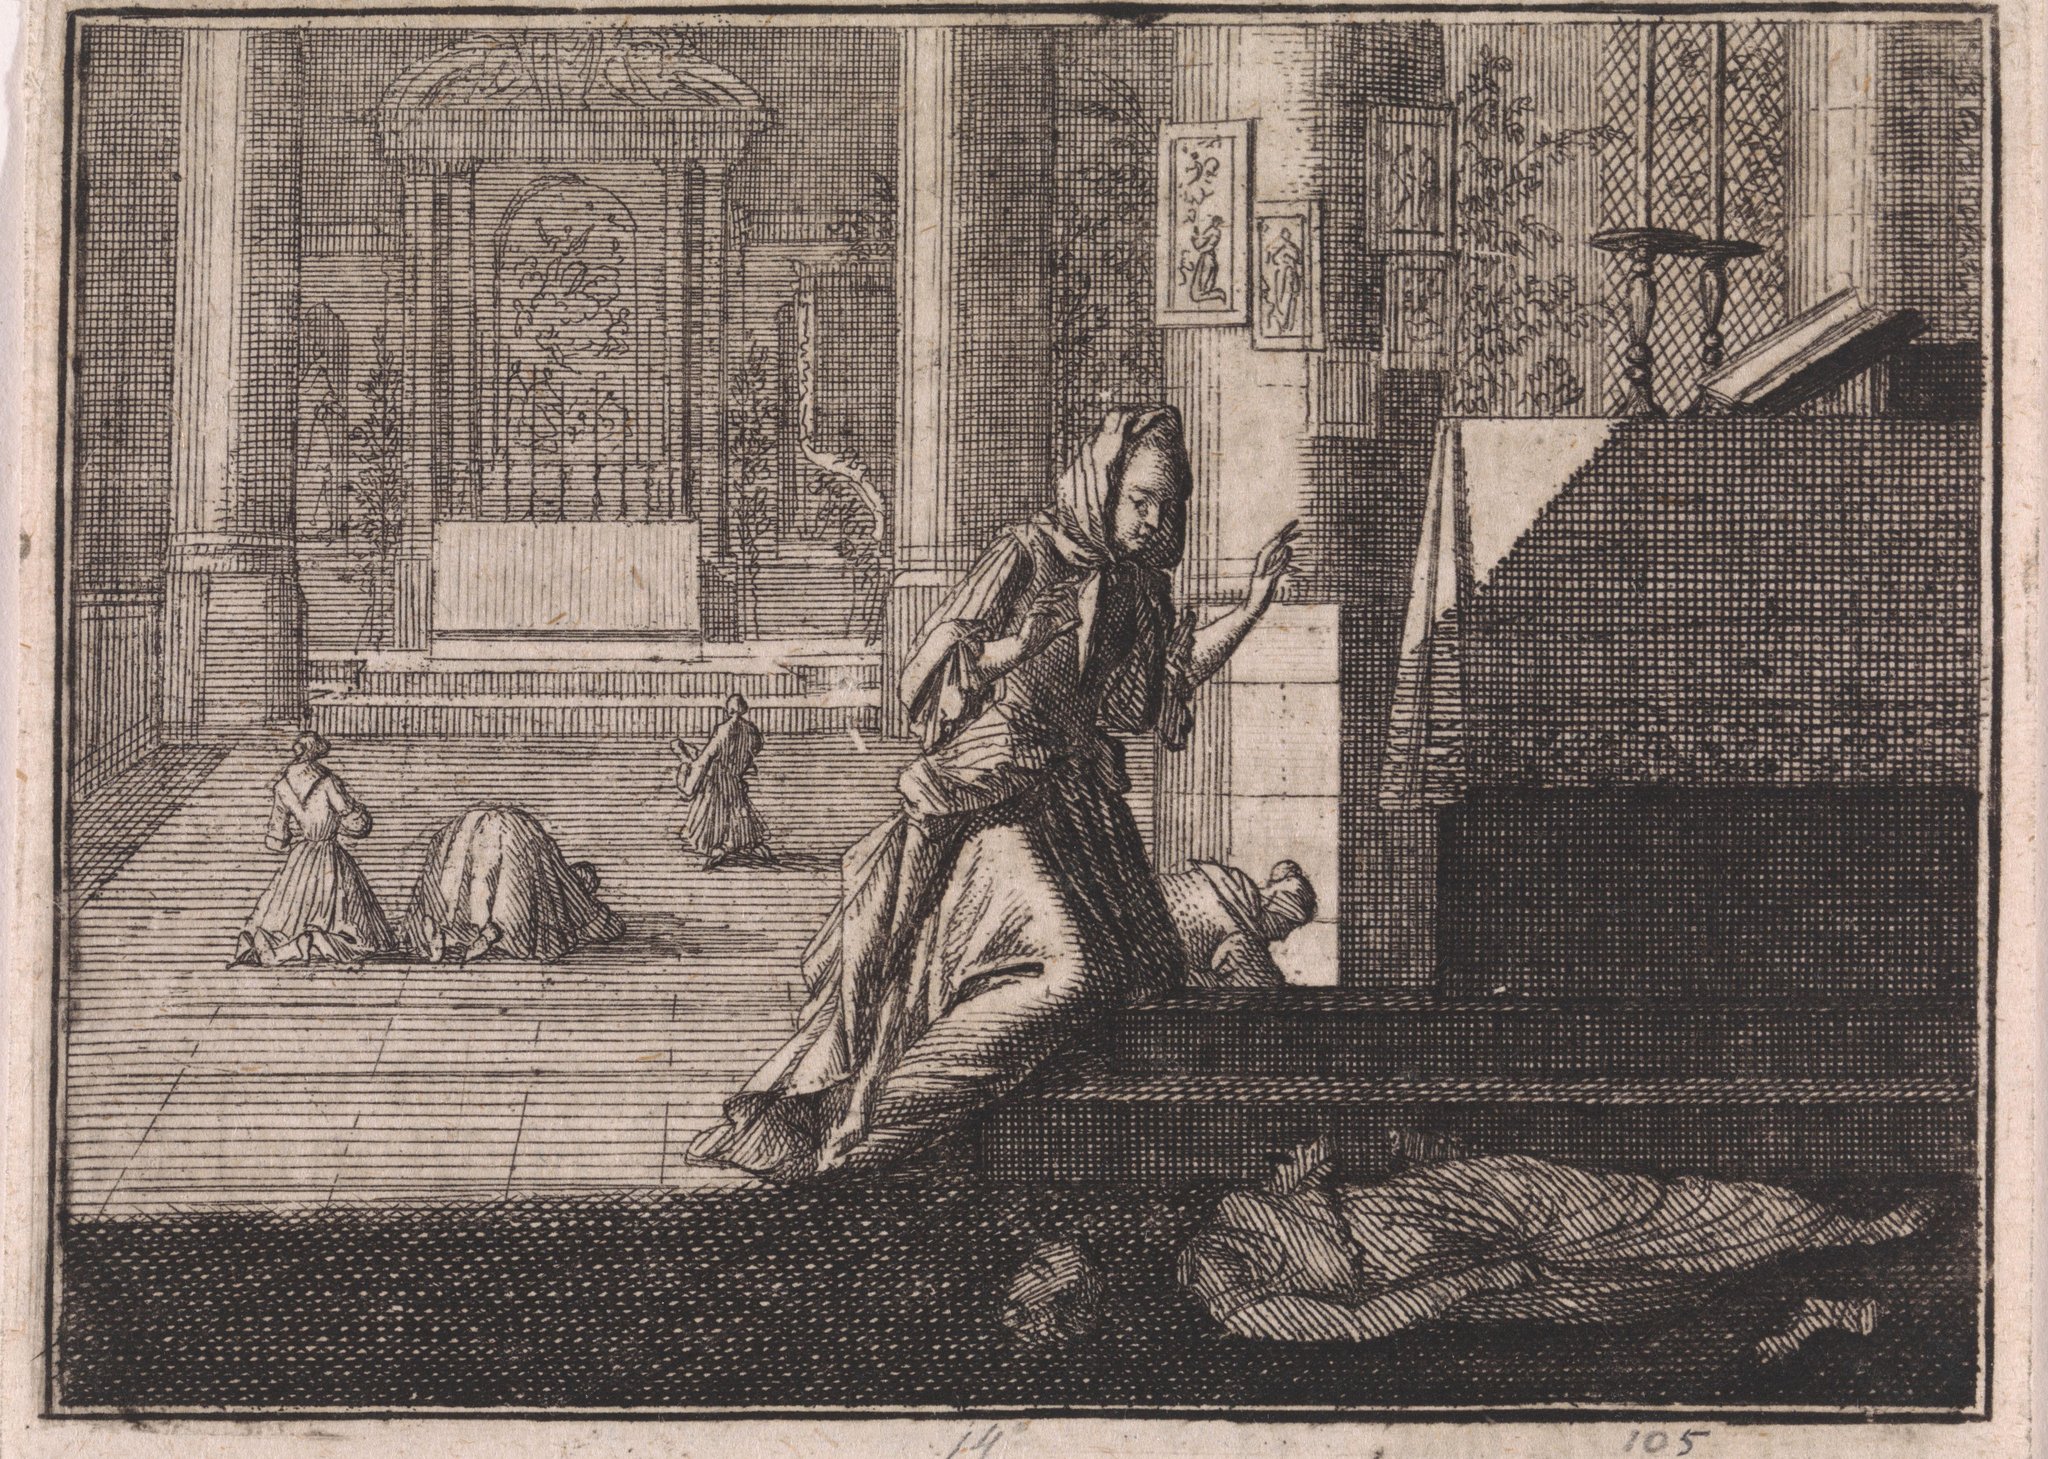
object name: book illustration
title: Beten ist nit allzeit gut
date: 1704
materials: paper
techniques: etching, letterpress printing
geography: nuremberg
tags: personal devotion of st. catherine, interior of church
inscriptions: collector's mark: Lugt 2228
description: Illustratie uit: Abraham a Sancta Clara. Heilsames Gemisch Gemasch, das ist: Allerley seltsame und verwunderliche Geschichten (...). Neurenberg: Christoph Weigel, 1704, p. 105.